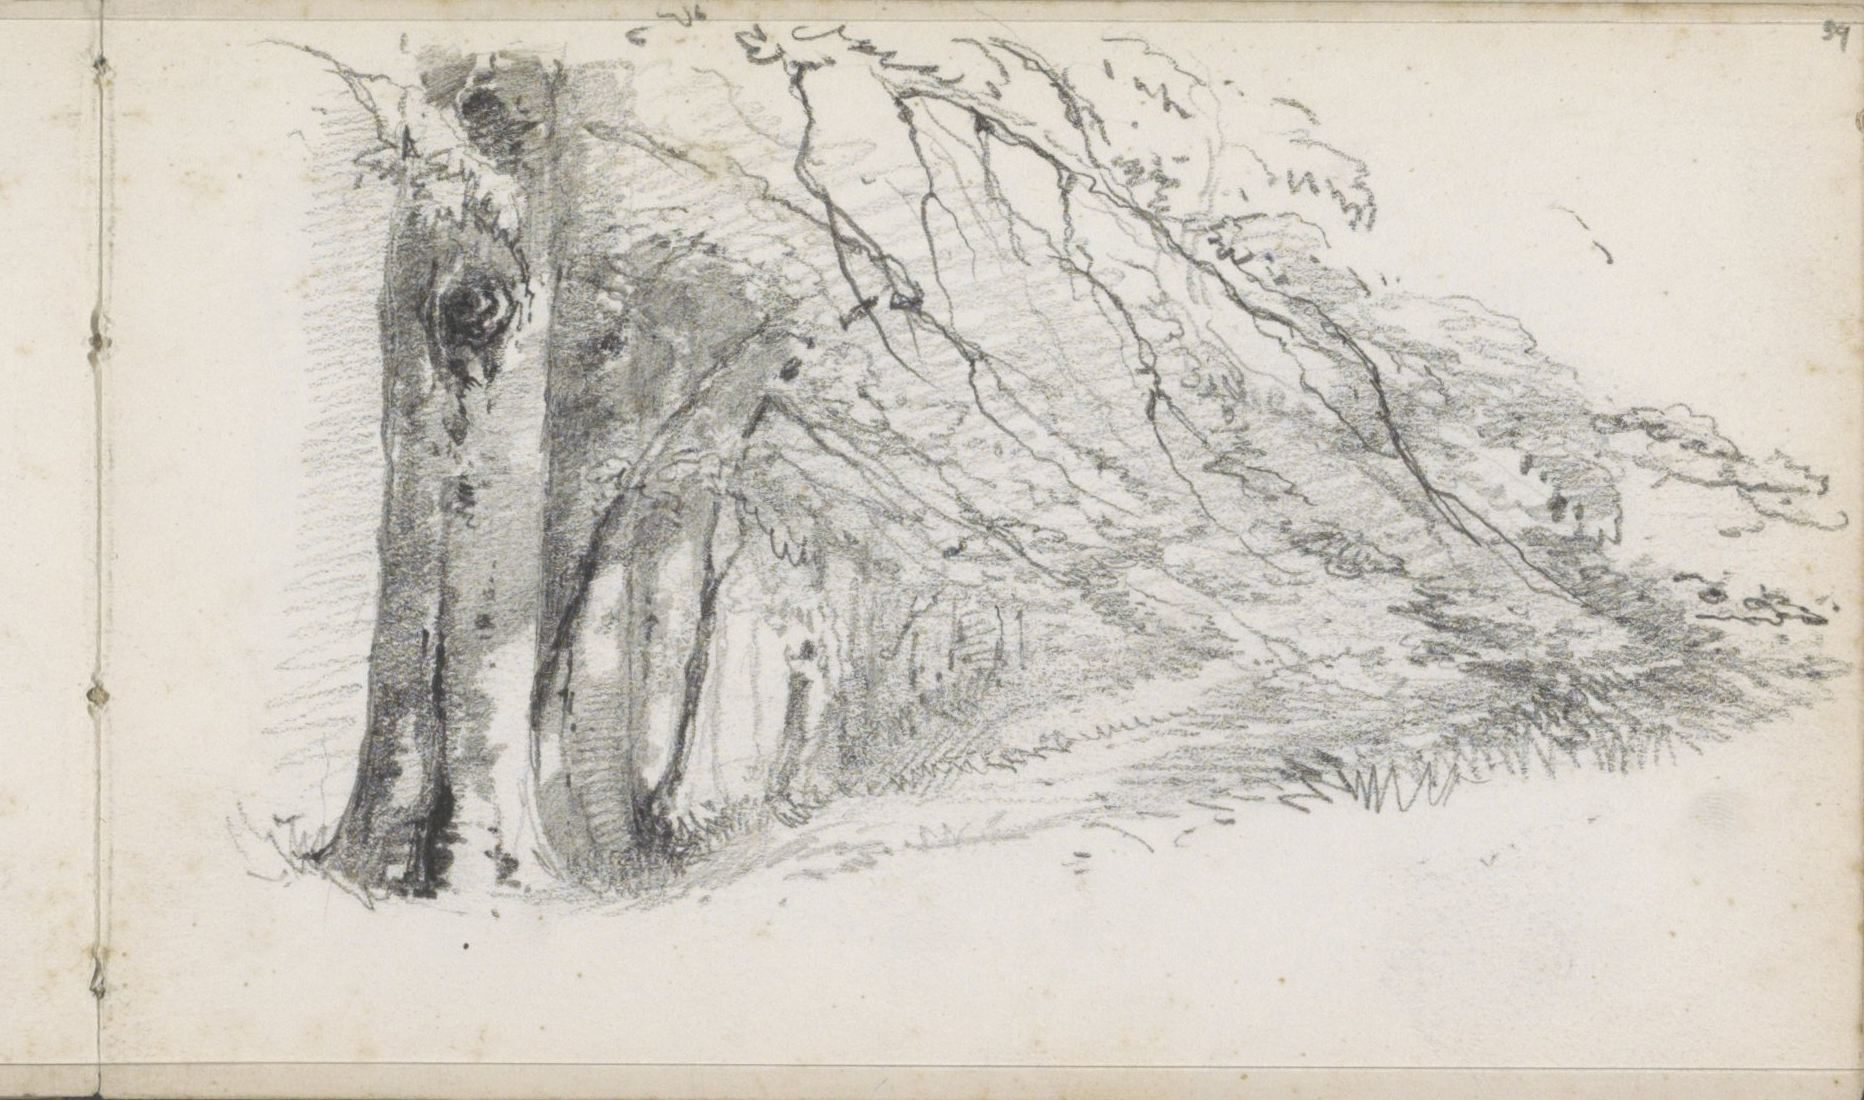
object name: sketchbook leaf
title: Bomen met laaghangende takken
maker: maria vos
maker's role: draughtsman, painter, print maker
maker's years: 1824-1906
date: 1863-1864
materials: paper, pencil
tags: trees, trees (+ branch, stick)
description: Blad 39 recto uit een schetsboek met 41 bladen.